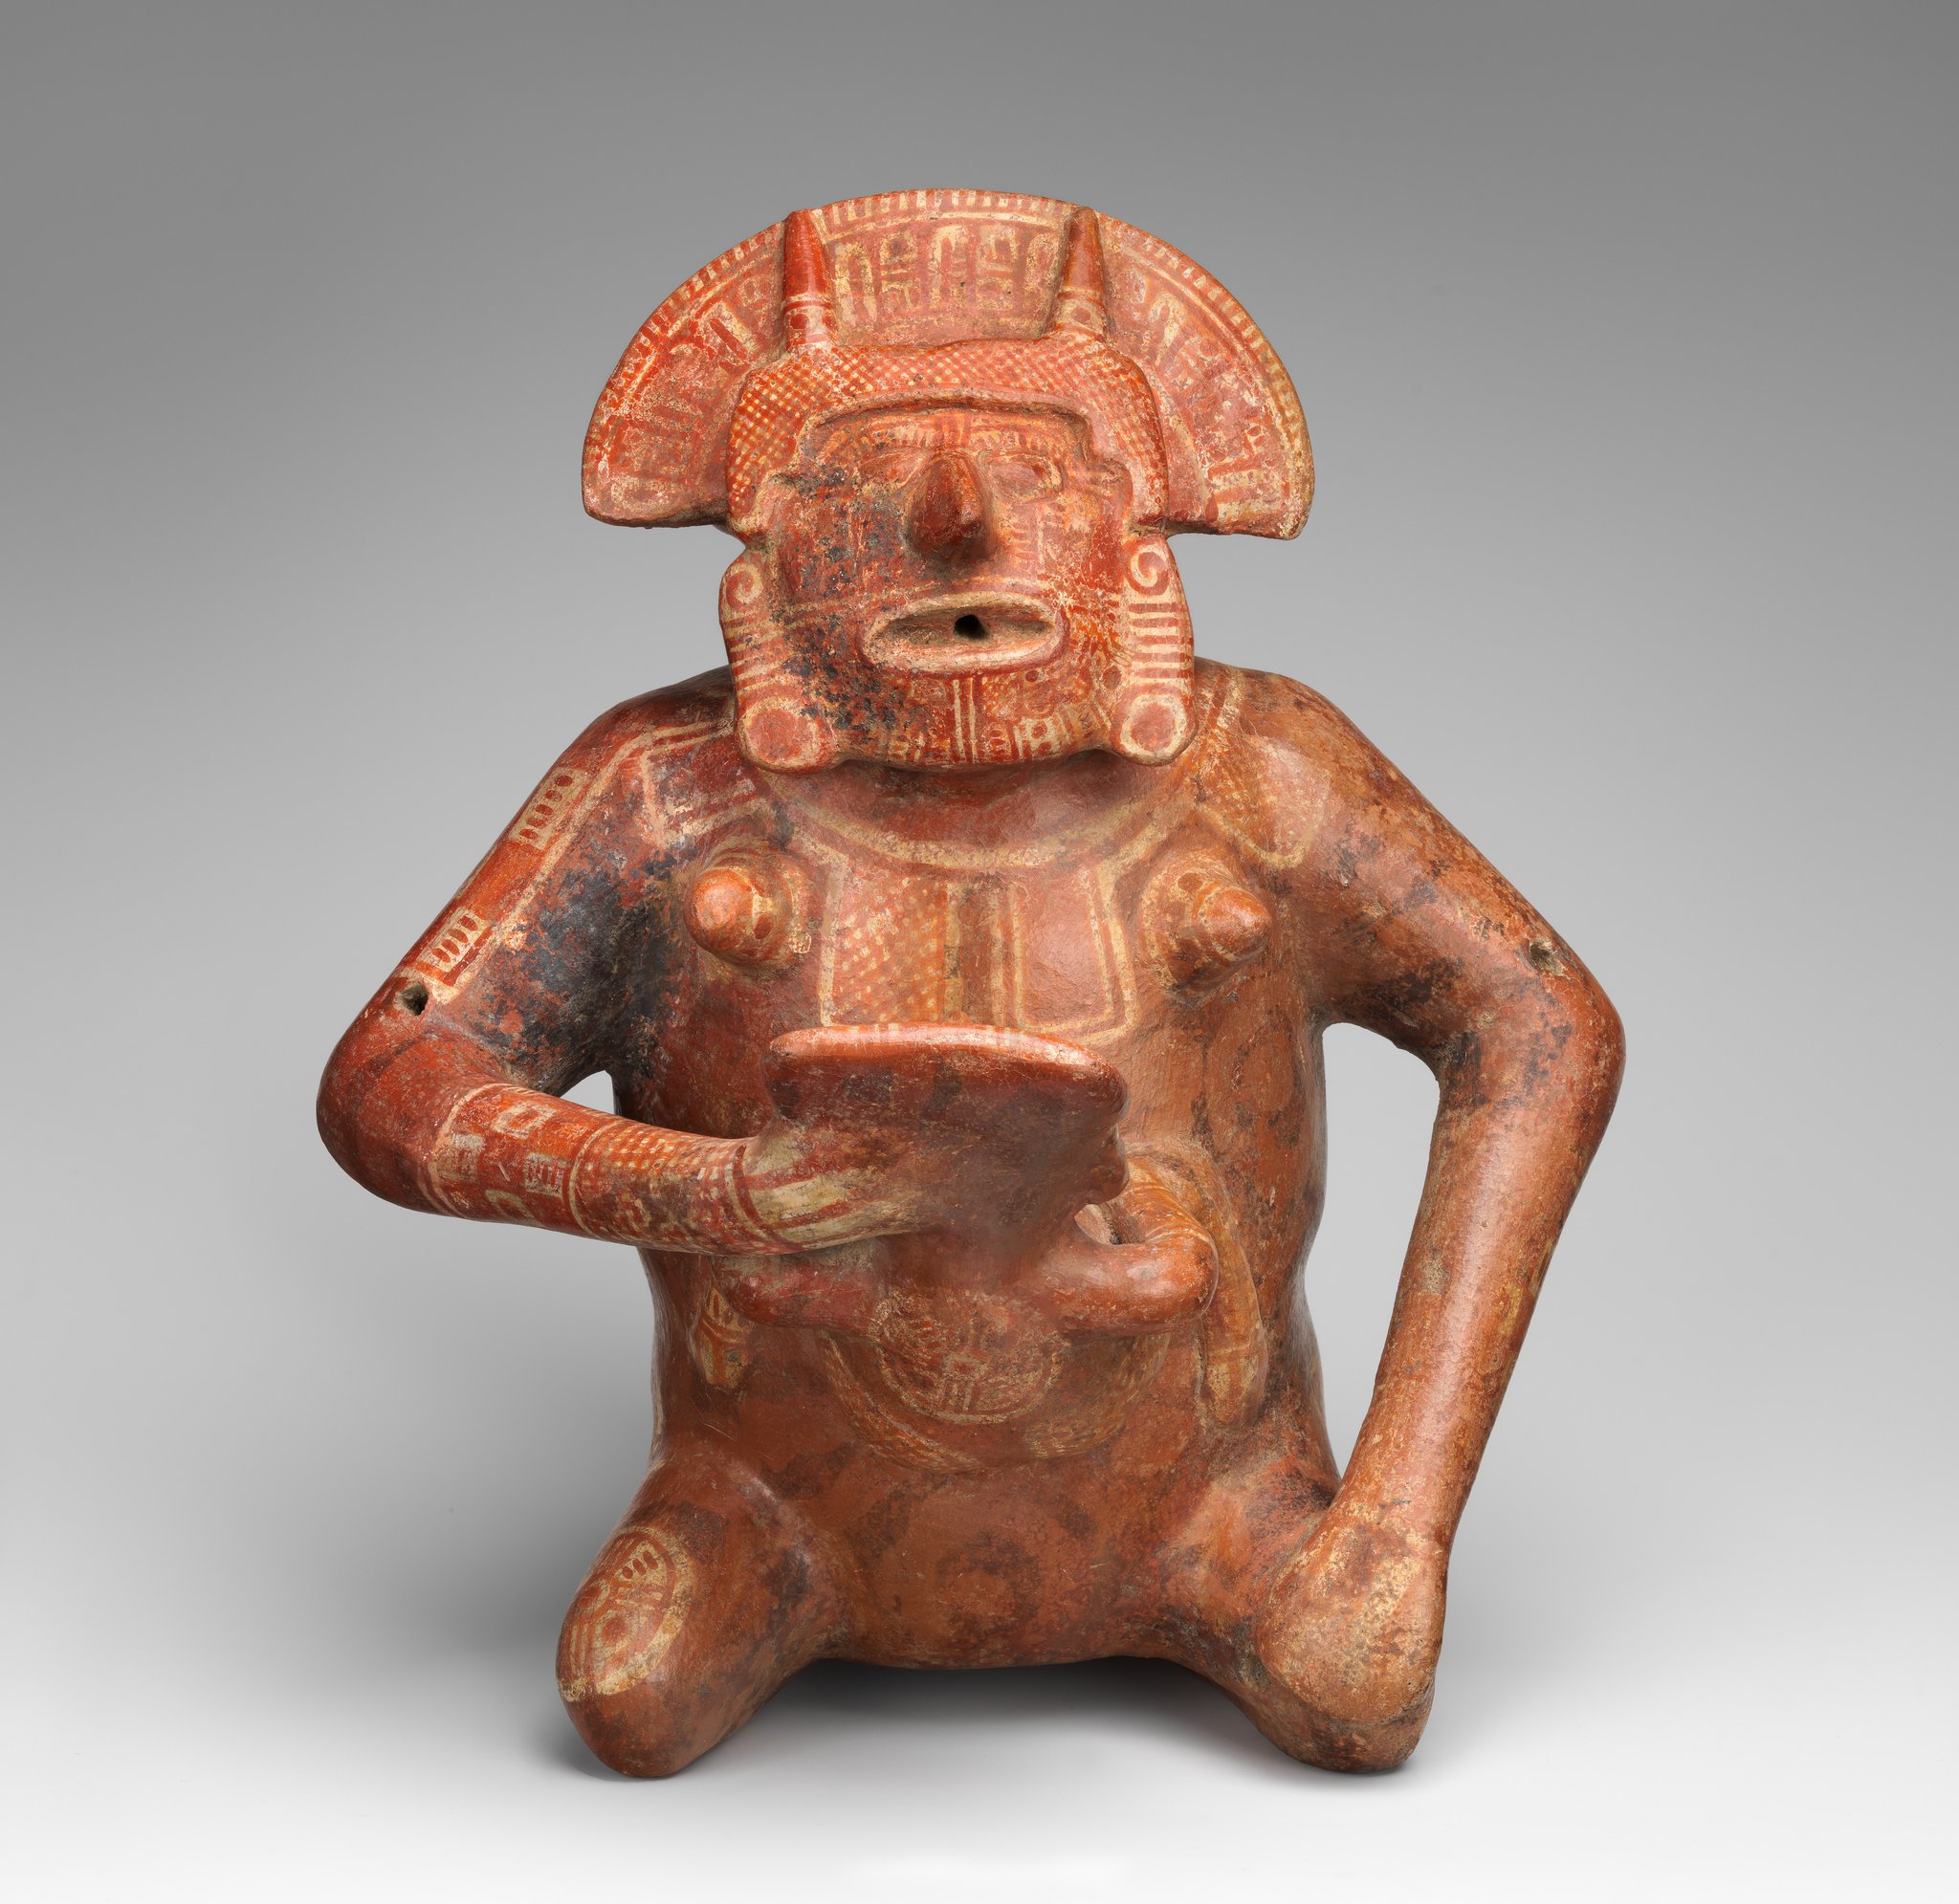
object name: vessel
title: Female effigy vessel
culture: colima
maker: colima artist(s)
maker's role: artist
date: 1200-1500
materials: ceramic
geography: mexico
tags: children,women